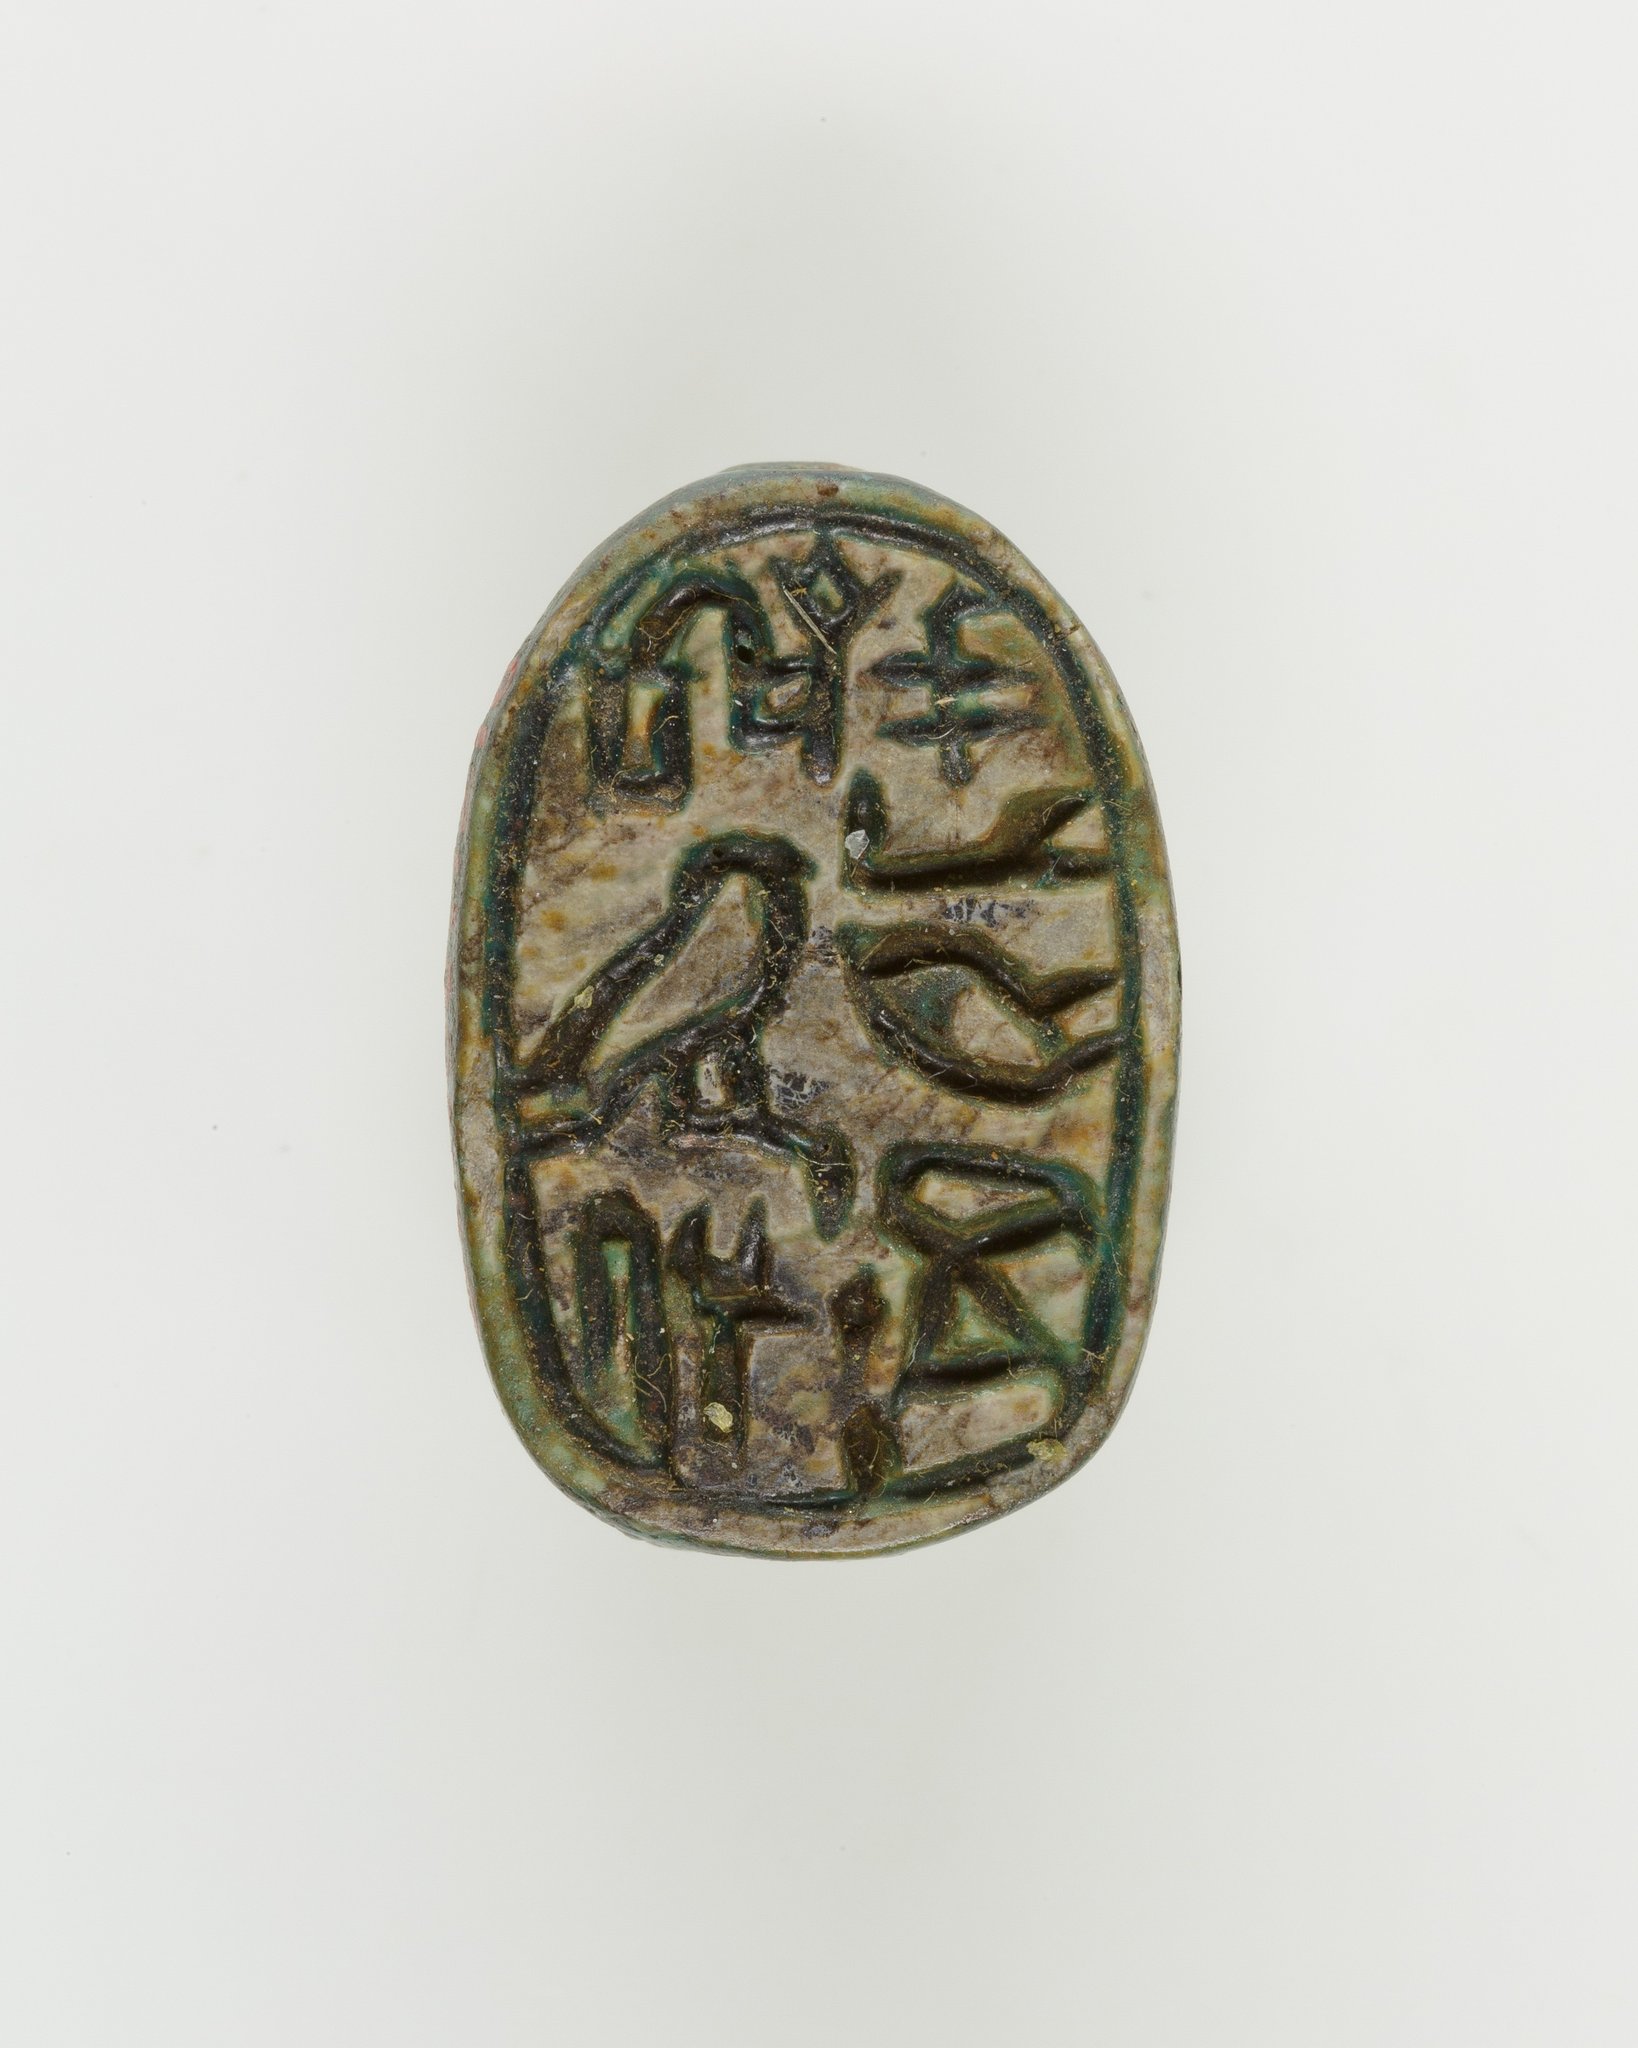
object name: scarab, official, private name and title, horuser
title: Scarab of an Official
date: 1760-1670 BCE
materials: stone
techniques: glazing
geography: egypt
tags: hieroglyphs,scarabs